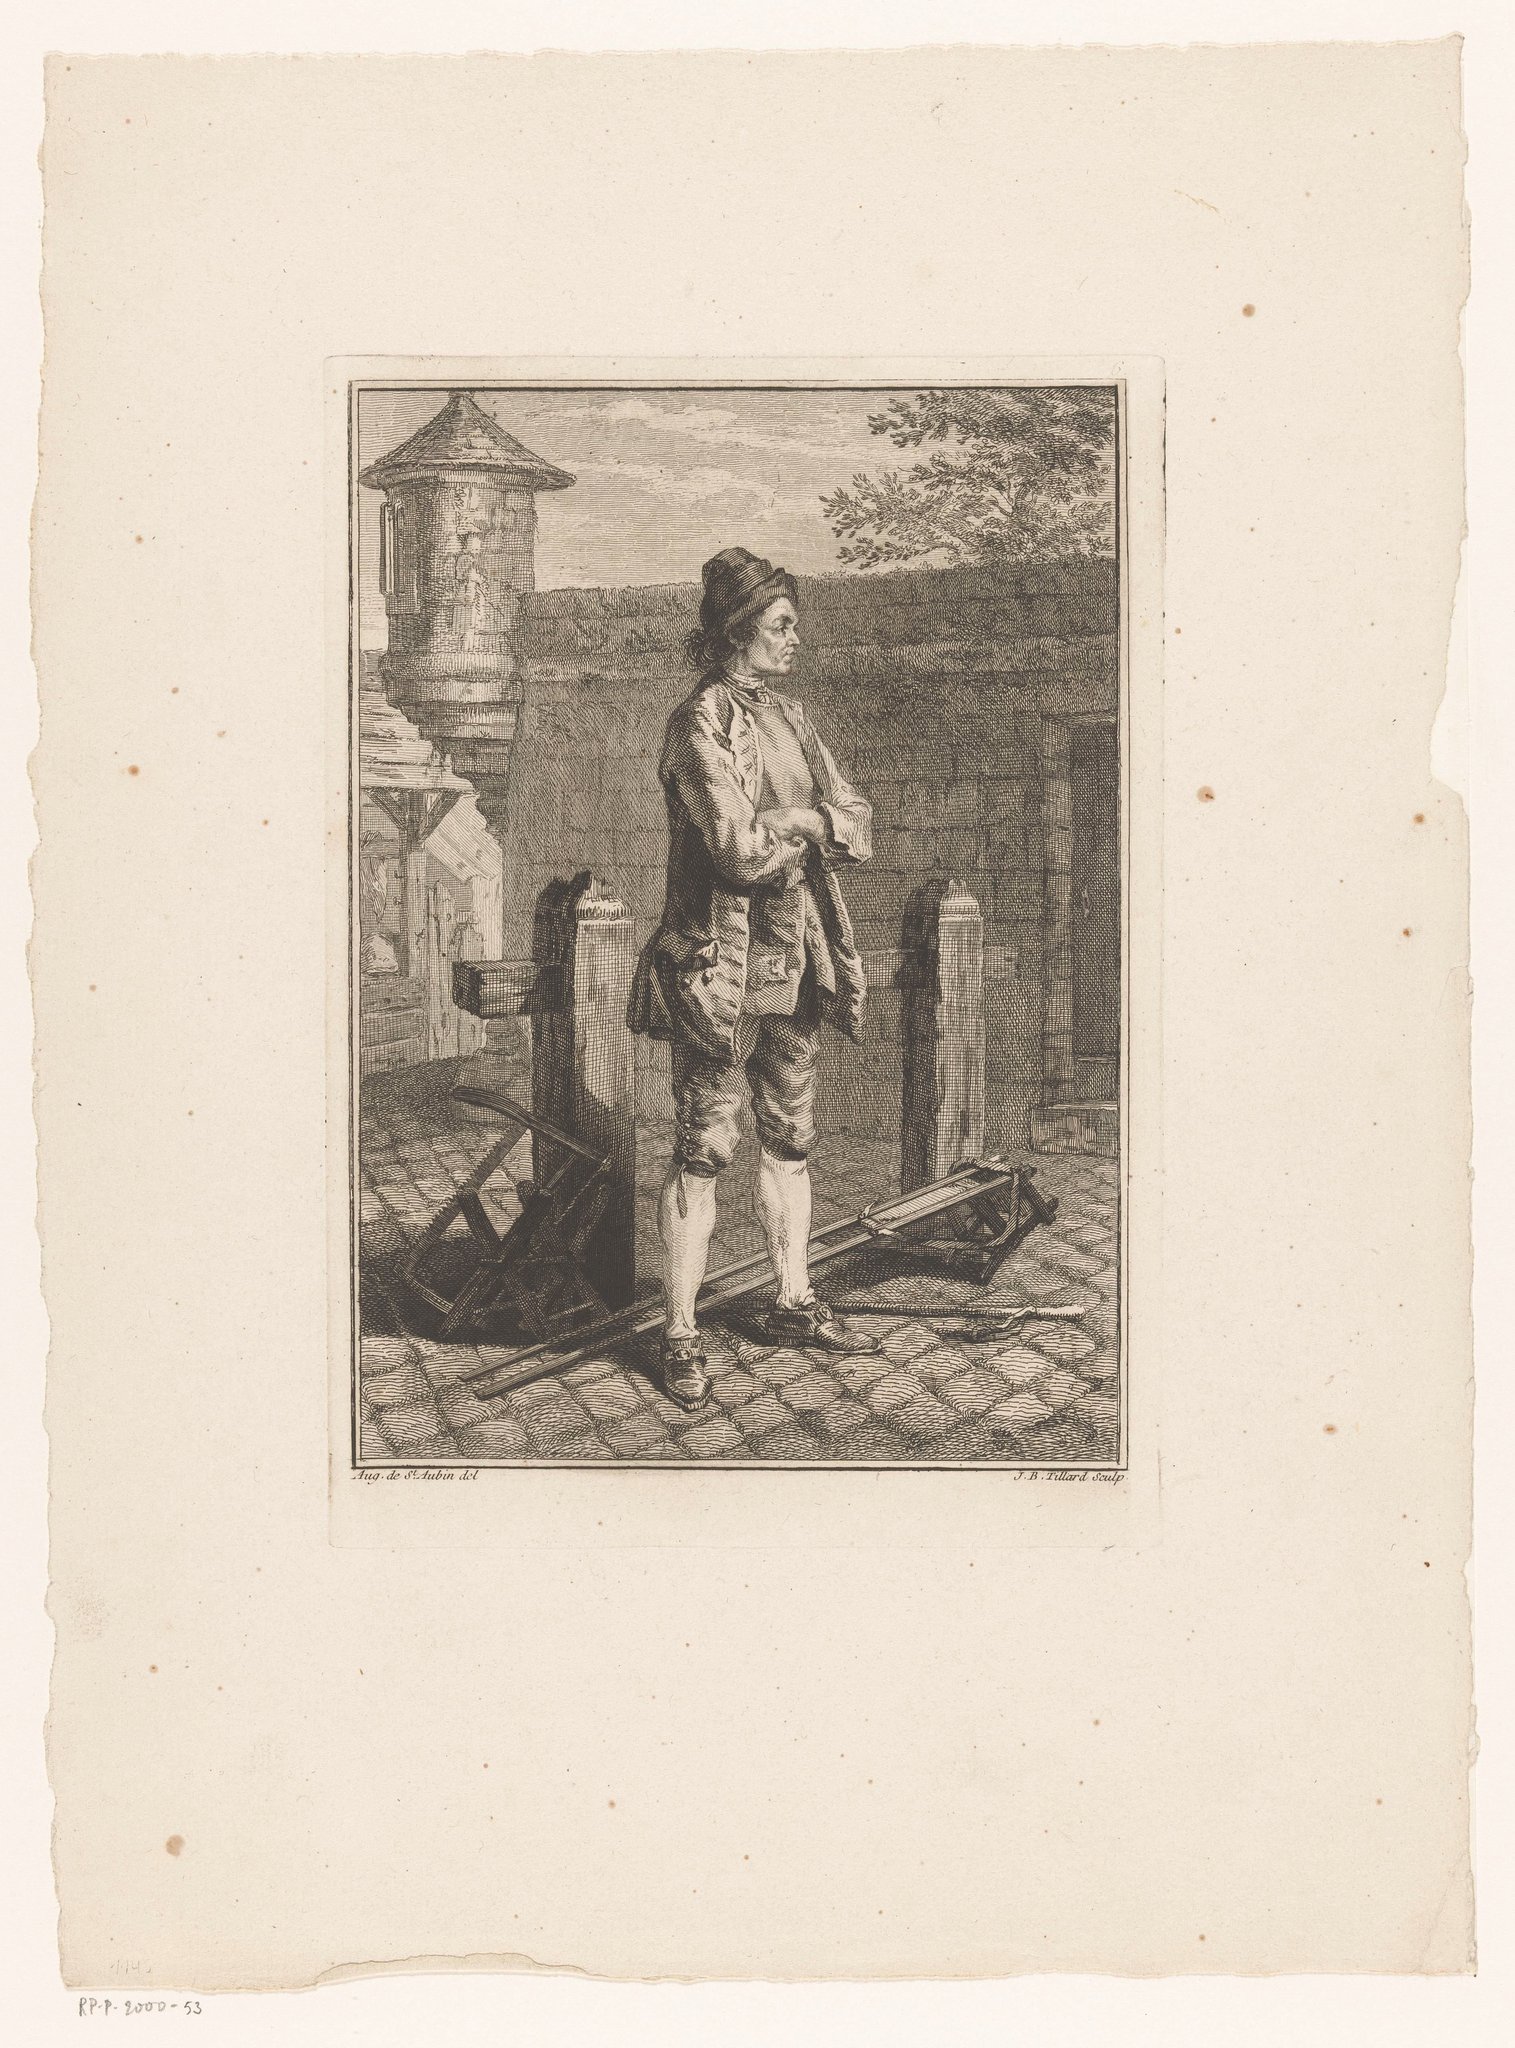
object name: print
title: Mes Gens, ou les Commissionaires ultramontains, Les Savoyards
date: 1766-1770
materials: paper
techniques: engraving, etching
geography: france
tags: carpenter, 'fahrende leute', vagrants, city-walls, tools, aids, implements ~ crafts and industries: saw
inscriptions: signature: ‘J.B. Tillard sculp.’, collector's mark: Lugt 2228, signature: ‘Aug. de St. Aubin del’, collector's mark: Lugt 2760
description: Maakt deel uit van een serie getiteld: "Mes Gens, ou les Commissionaires ultramontains, Les Savoyards", uitgegeven door Basan en de Saint-Aubin. De serie bestaat uit zes platen en een frontispice. Bij een latere editie is een achtste plaat toegevoegd.